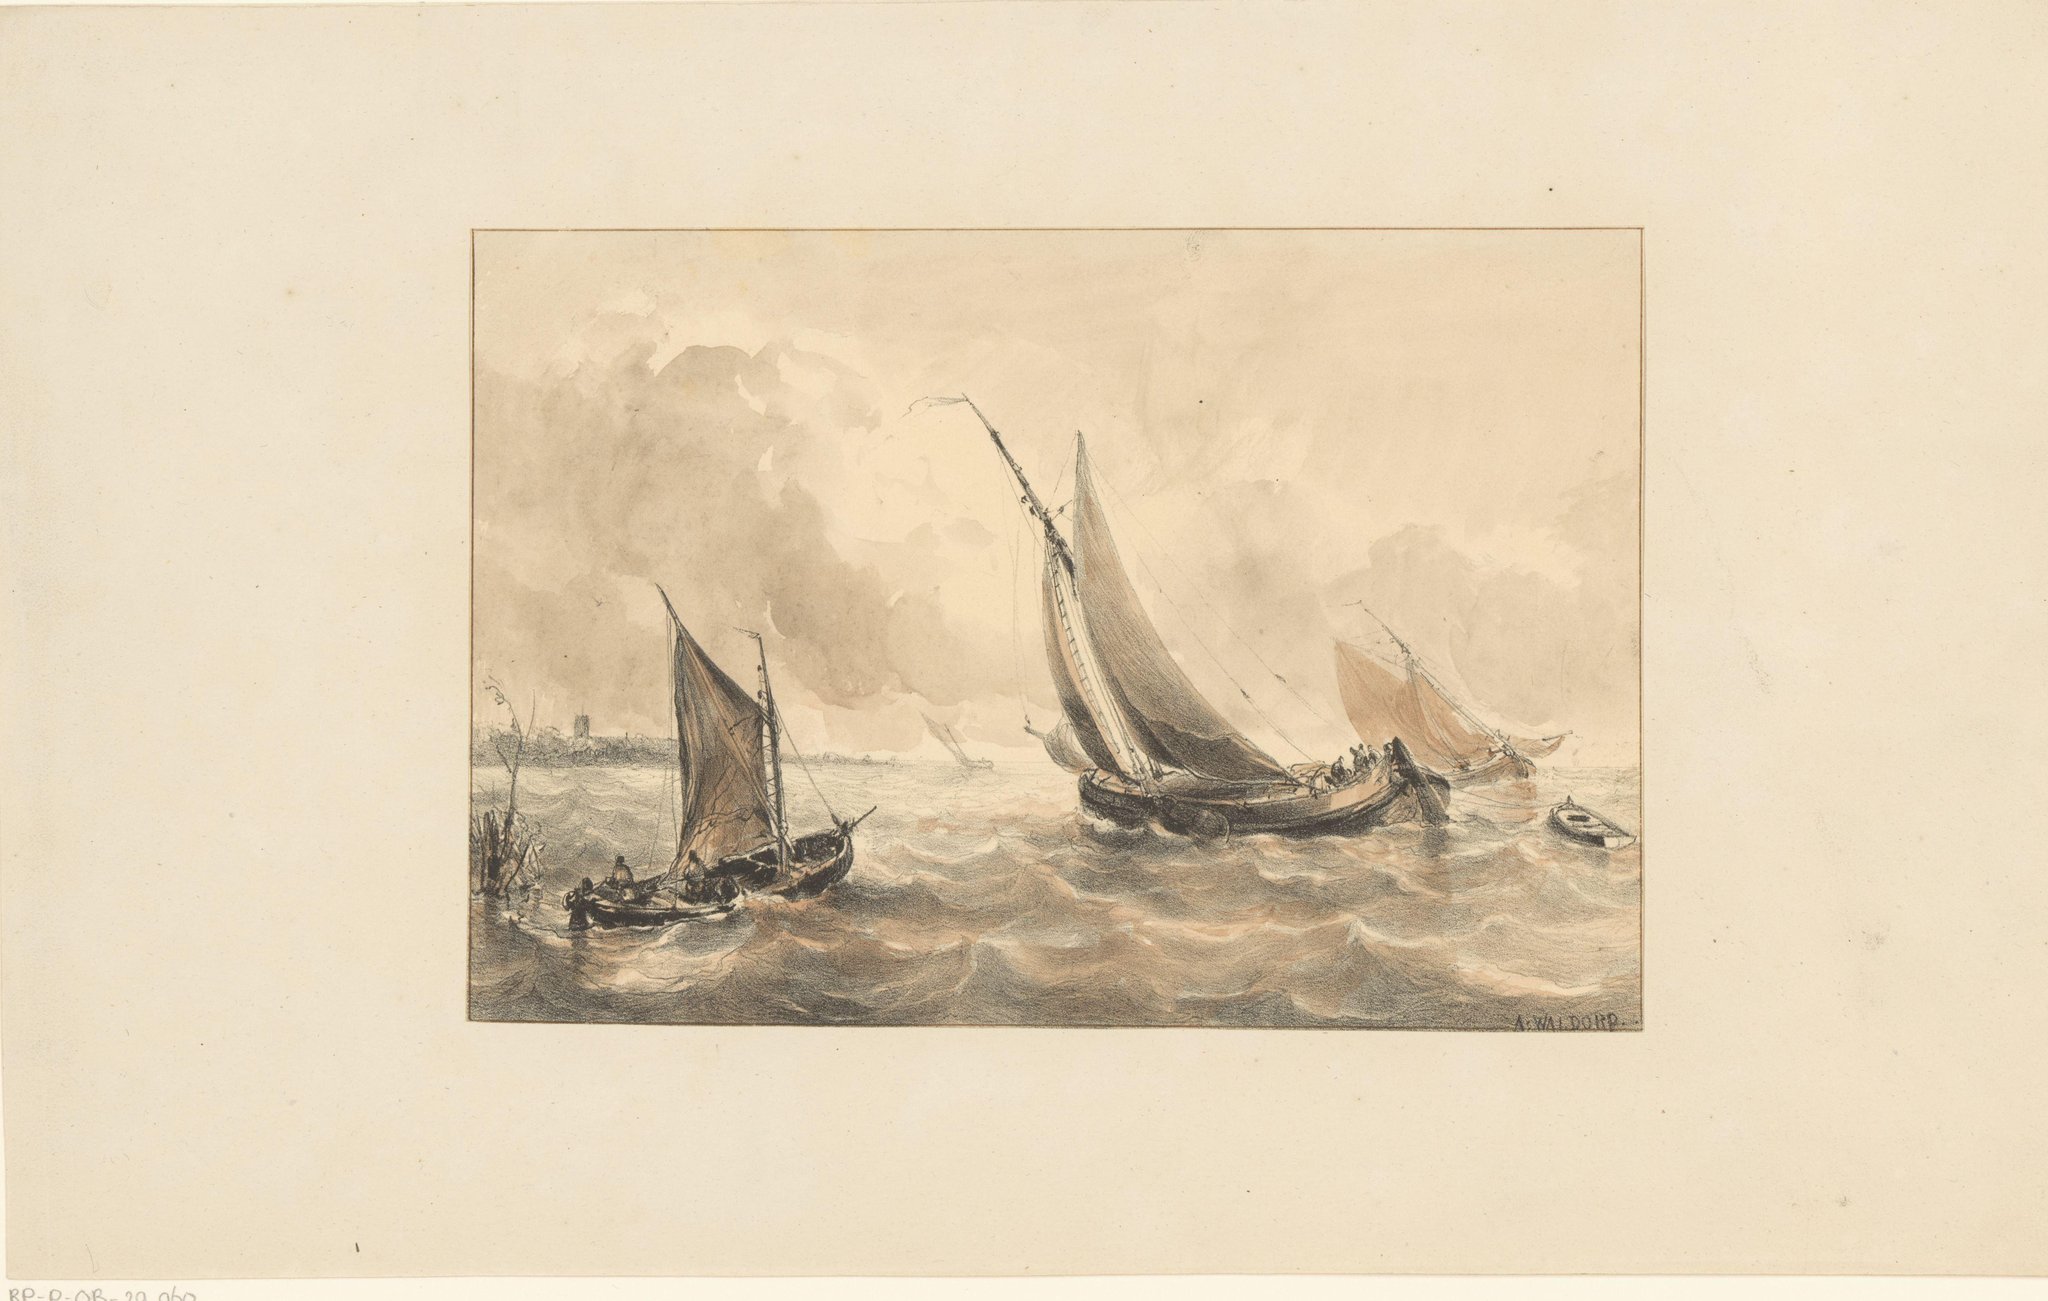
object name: print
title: Zeilboten op zee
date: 1813-1866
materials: paper, watercolor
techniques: brush, lithograph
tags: sailing-ship, sailing-boat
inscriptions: collector's mark: Lugt 2228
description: Zeilboten op woelig water. In de achtergrond links de kust met een toren.